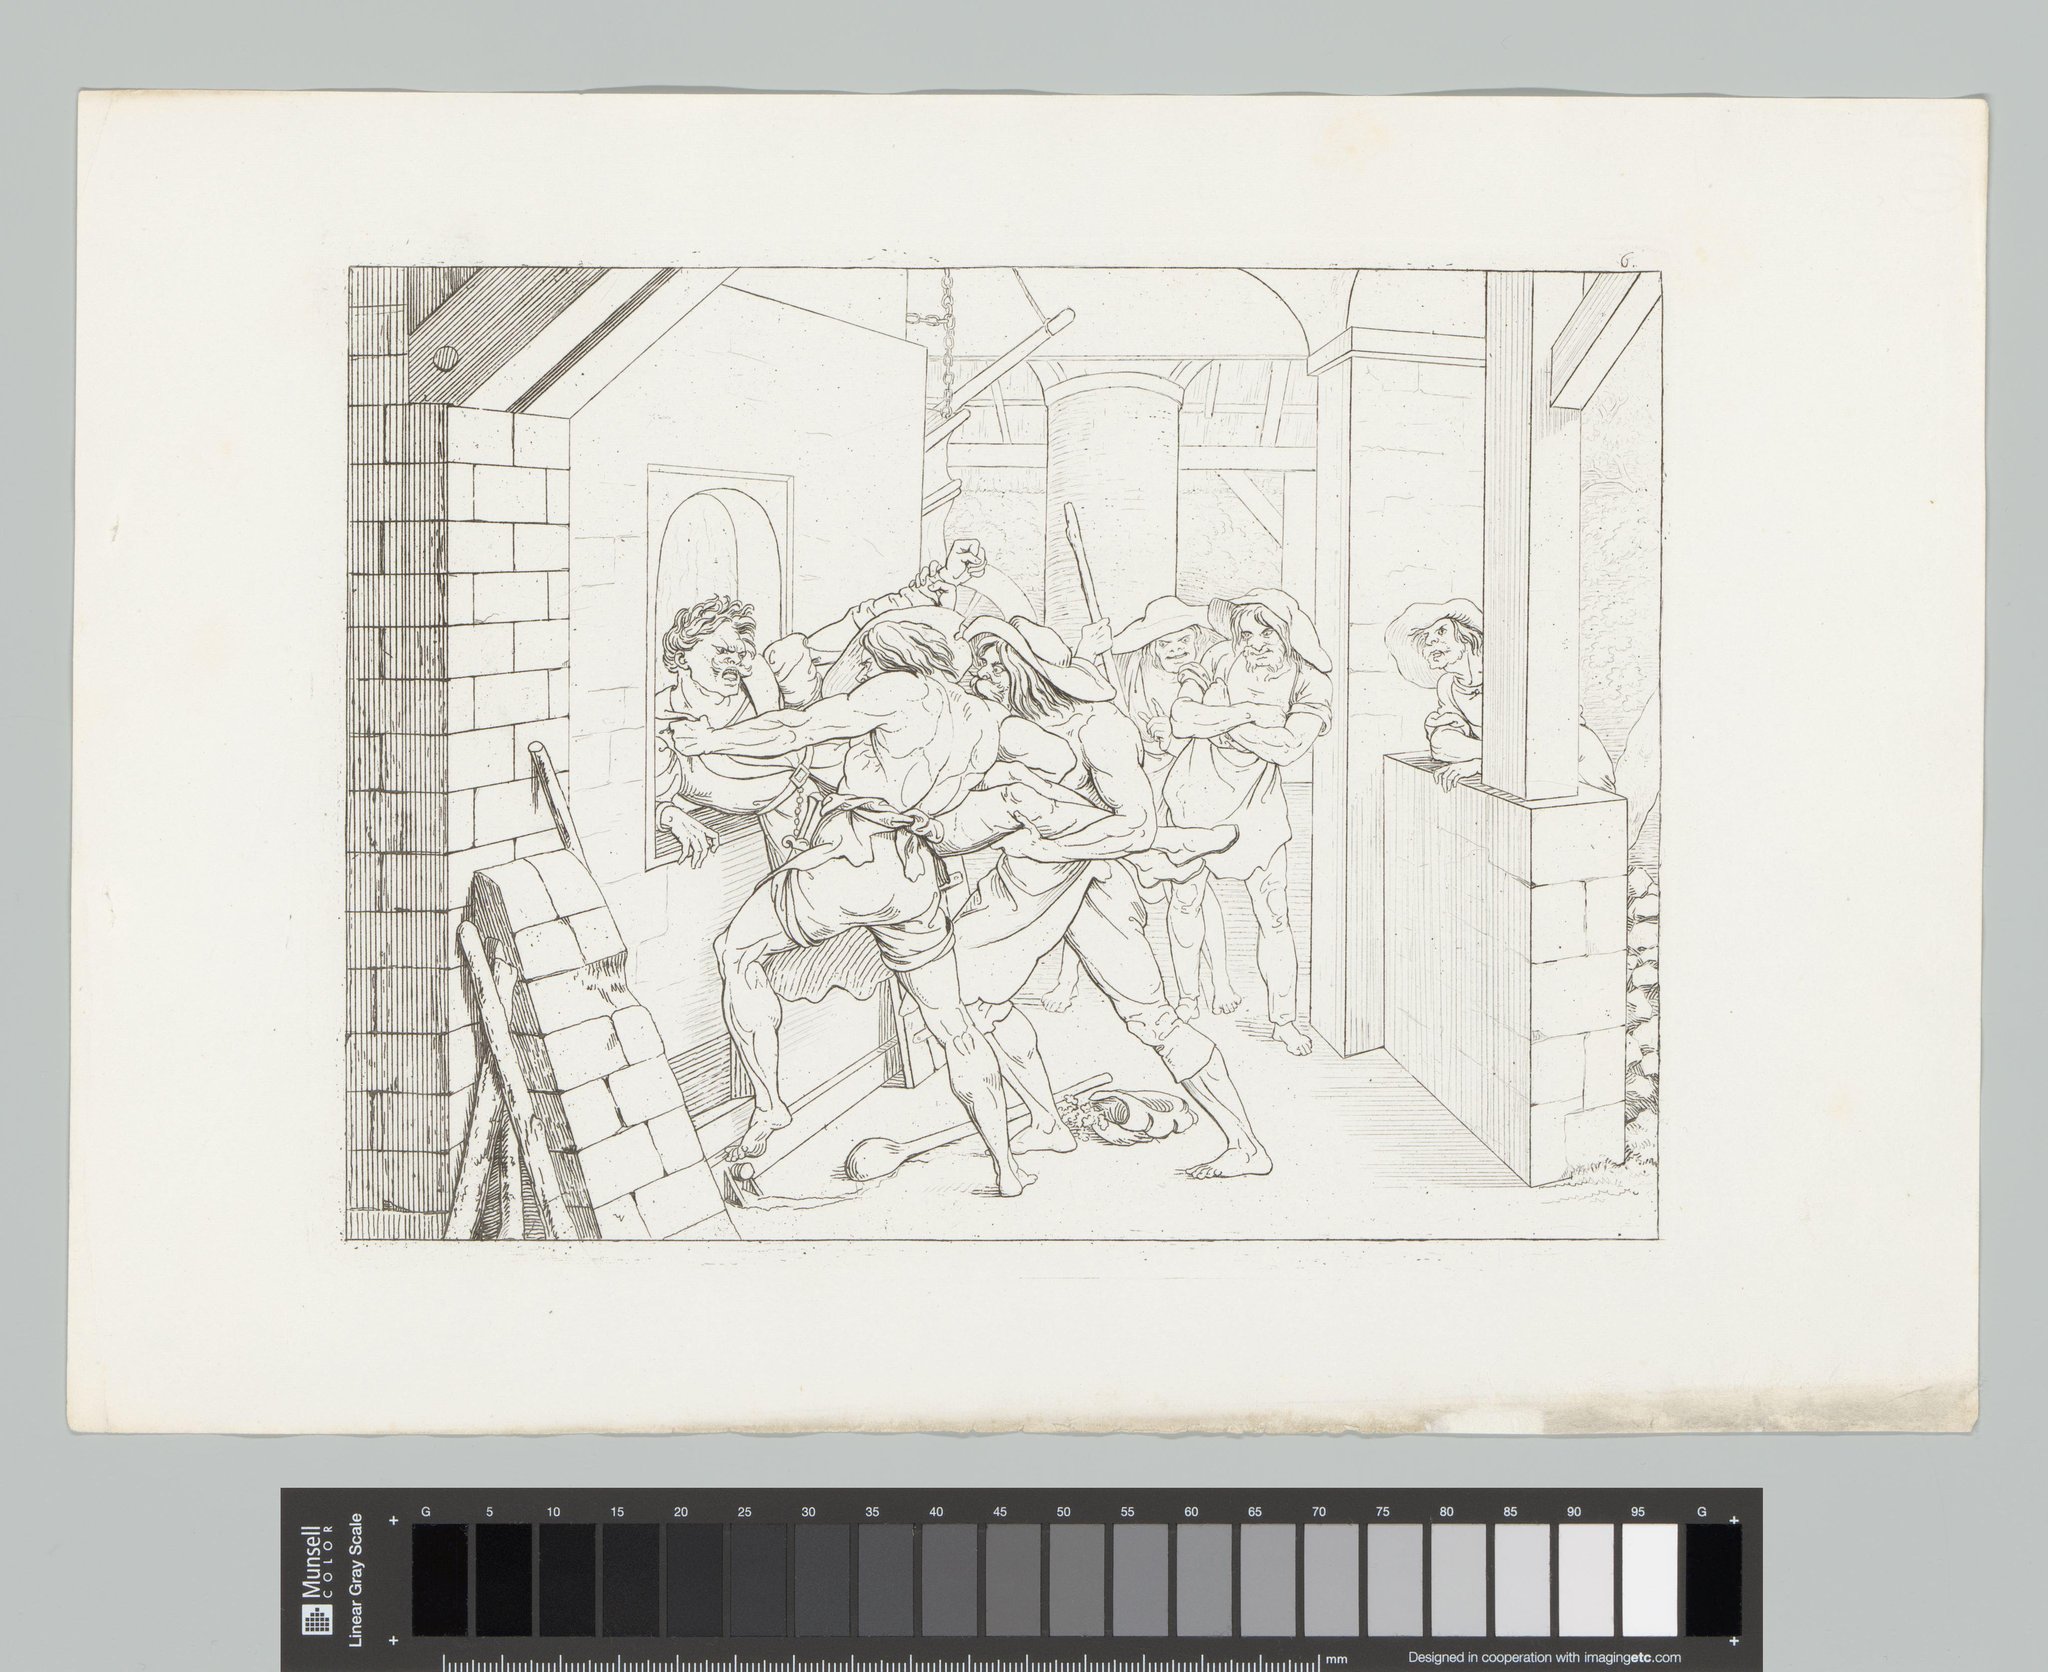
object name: print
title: Umrisse zu Schiller's Fridolin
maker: moritz retzsch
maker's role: print maker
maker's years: 1779-1857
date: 1823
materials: paper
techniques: etching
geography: stuttgart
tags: fire, oven, furnace ~ interior of industrial structure, smith, blacksmith, fighting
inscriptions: date